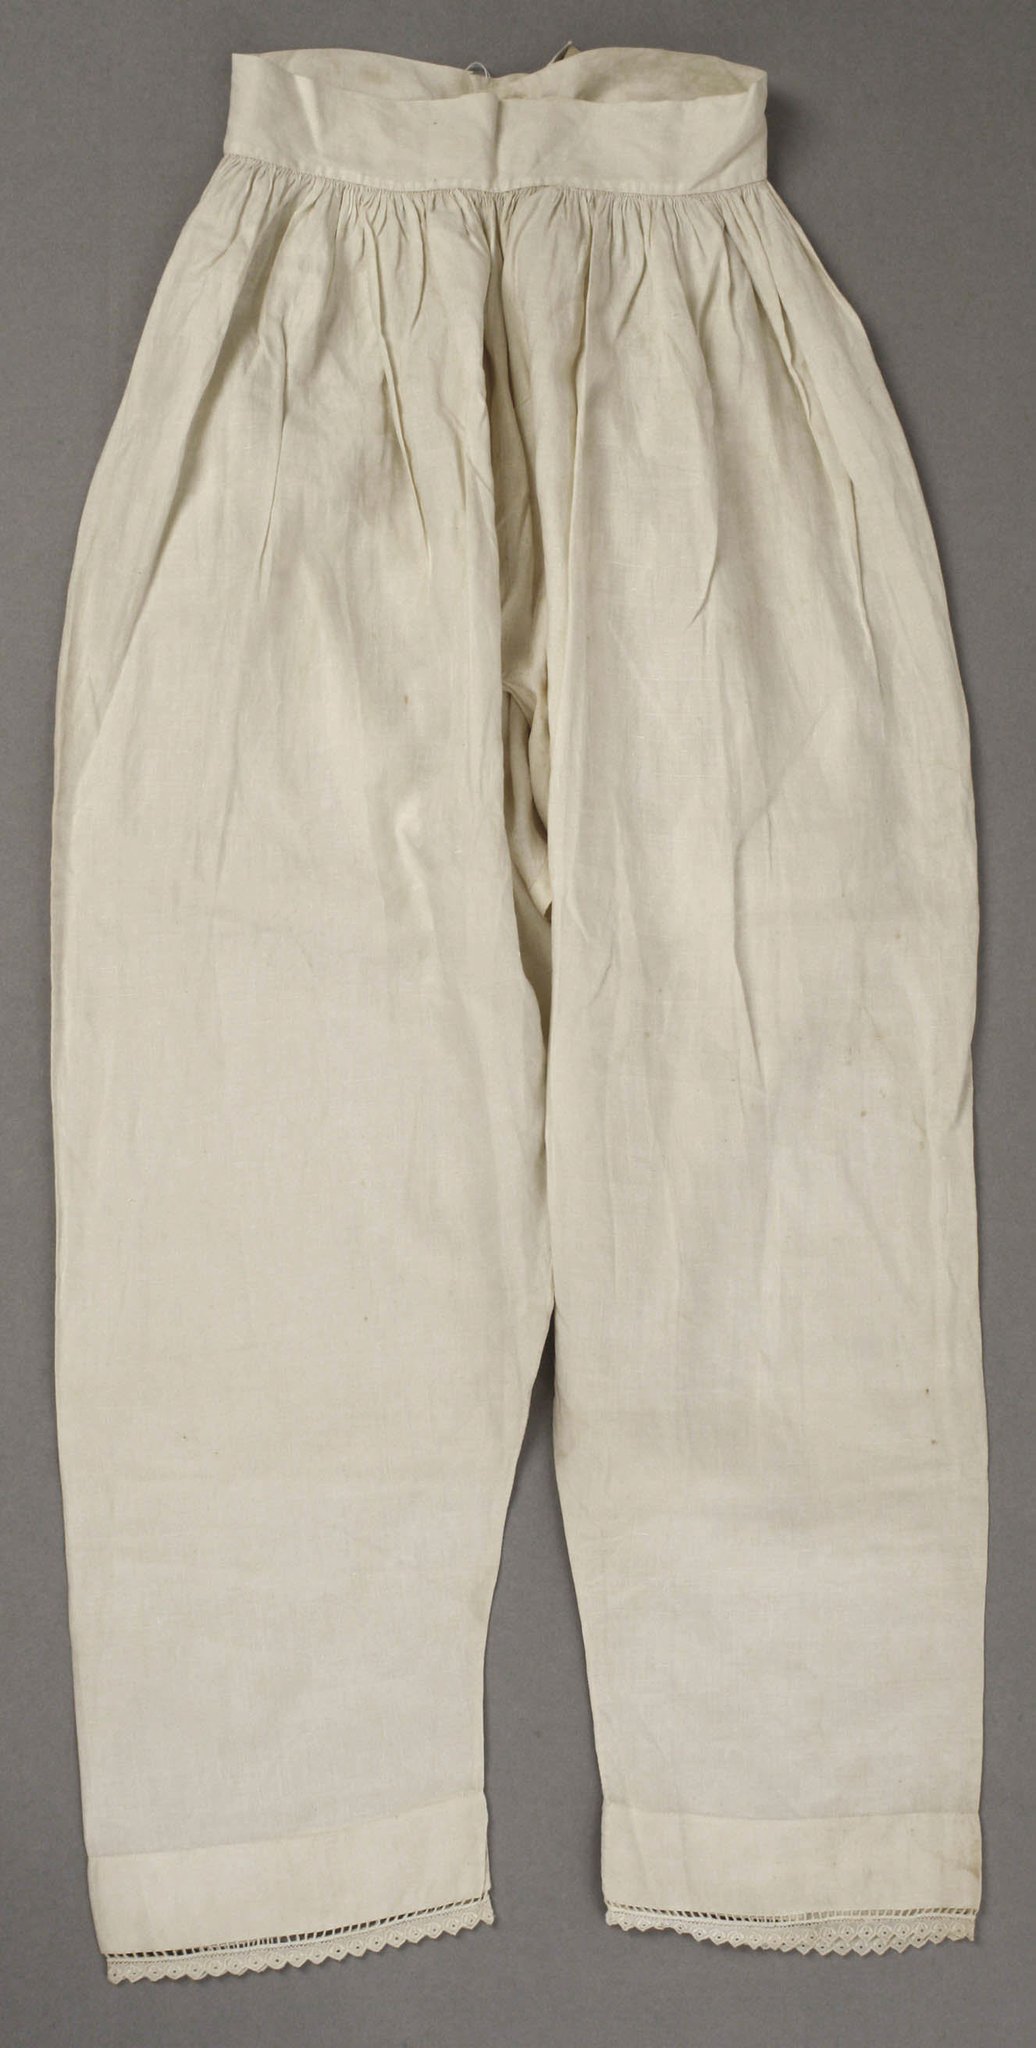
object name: pantalets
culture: american or european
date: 1846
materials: linen